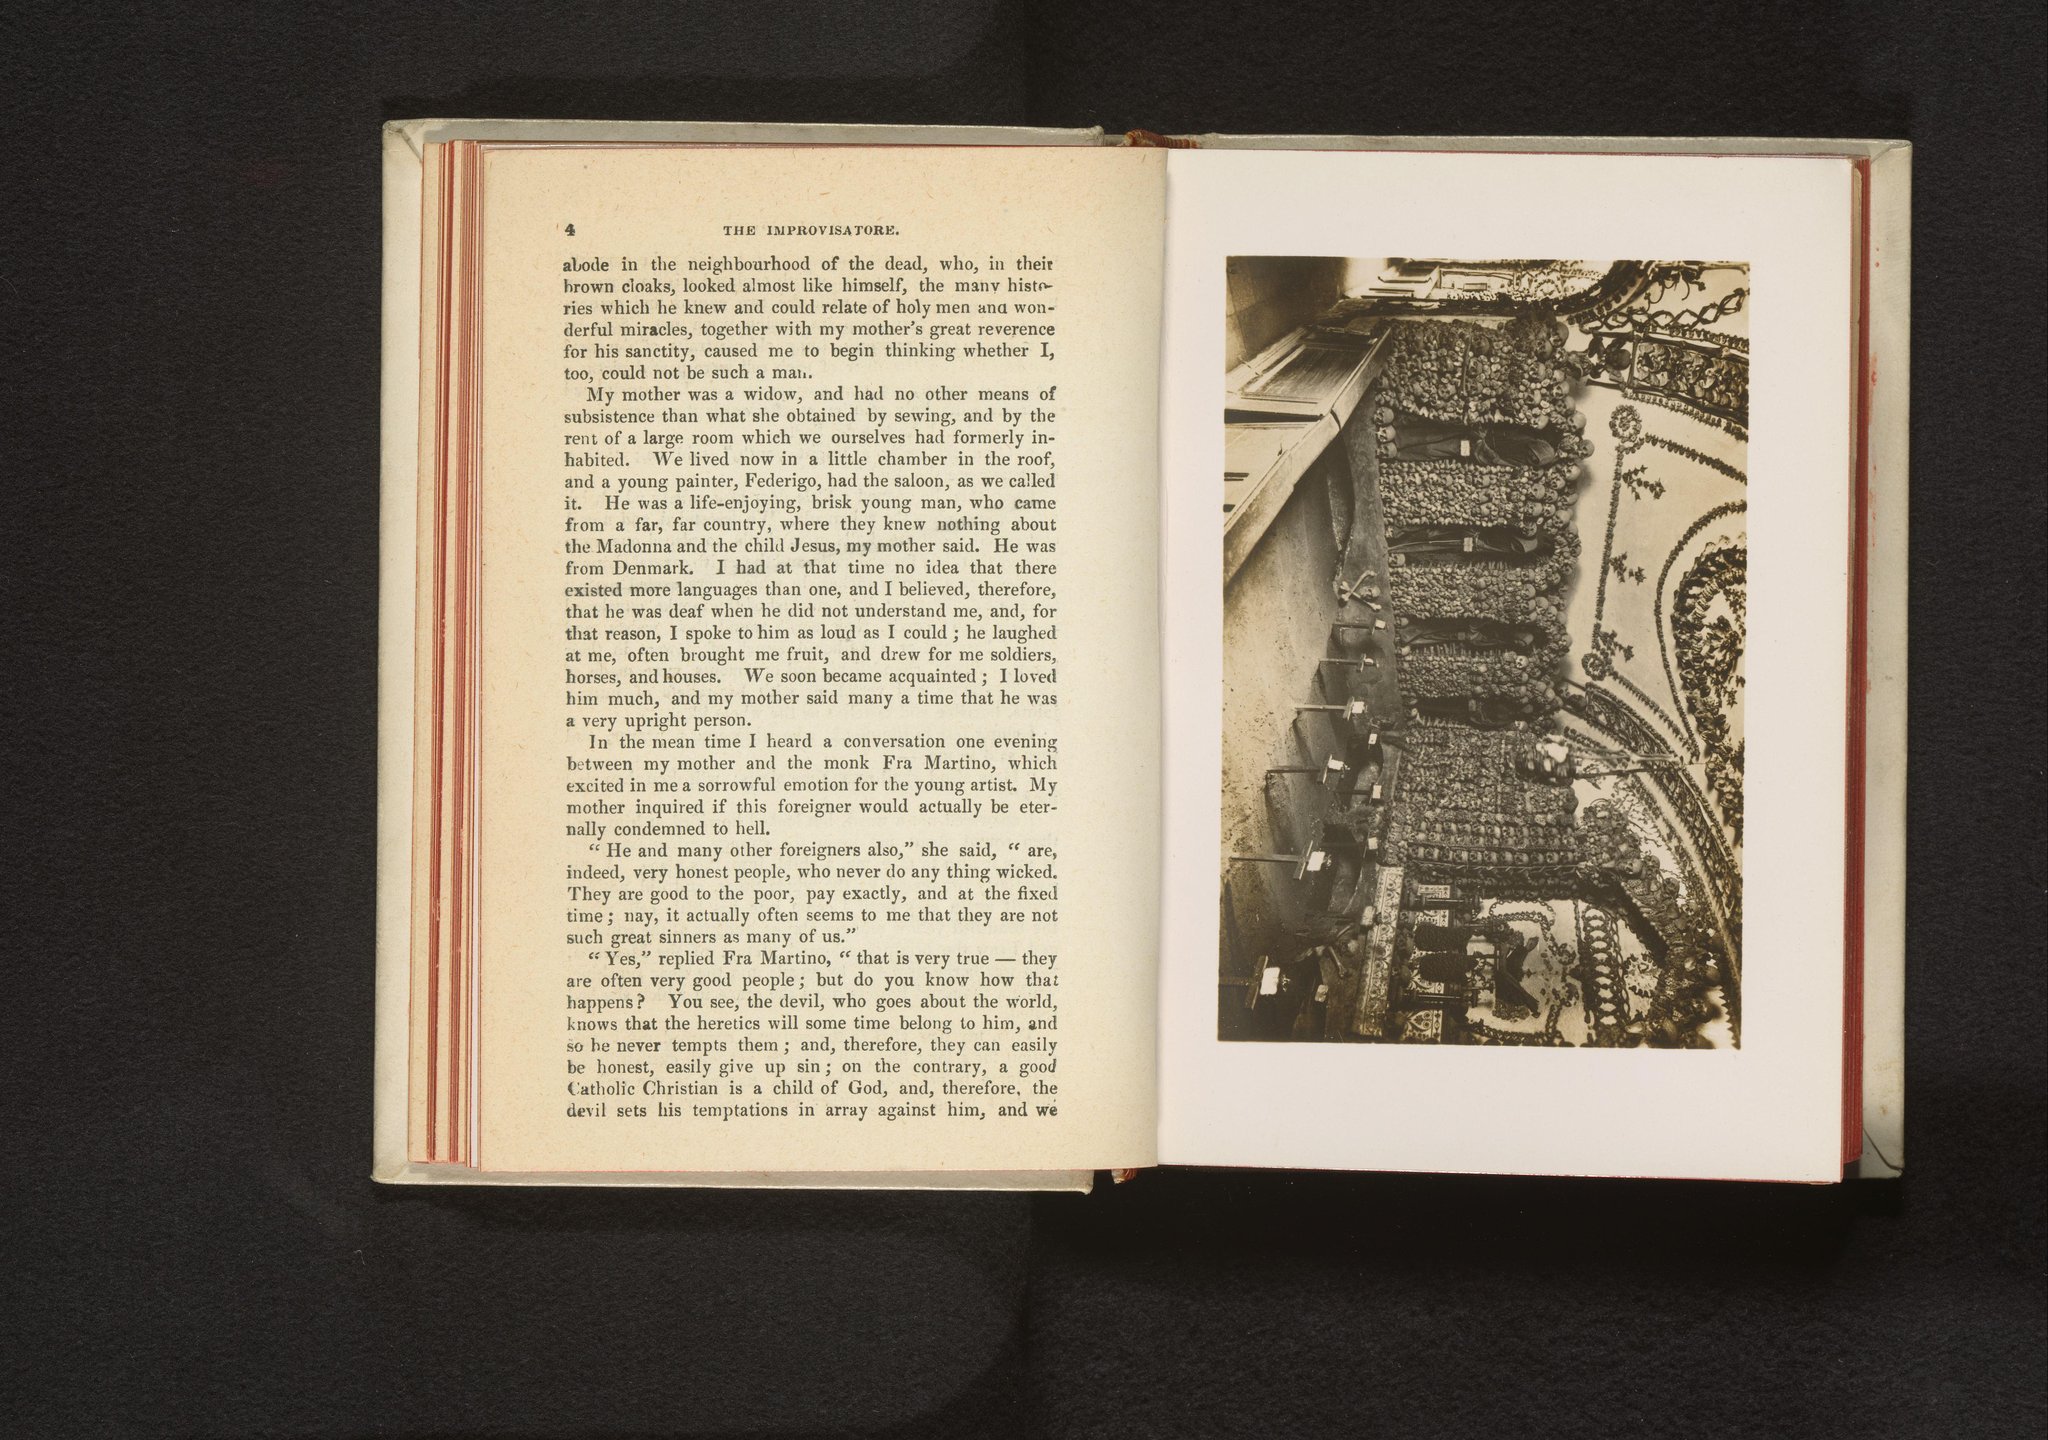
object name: page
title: Ossuarium van de Santa Maria della Concezione dei Cappuccini te Rome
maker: Anonymous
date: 1870-1880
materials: photographic support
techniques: gelatin silver print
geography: santa maria della concezione dei cappuccini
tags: charnelhouse, ossuary